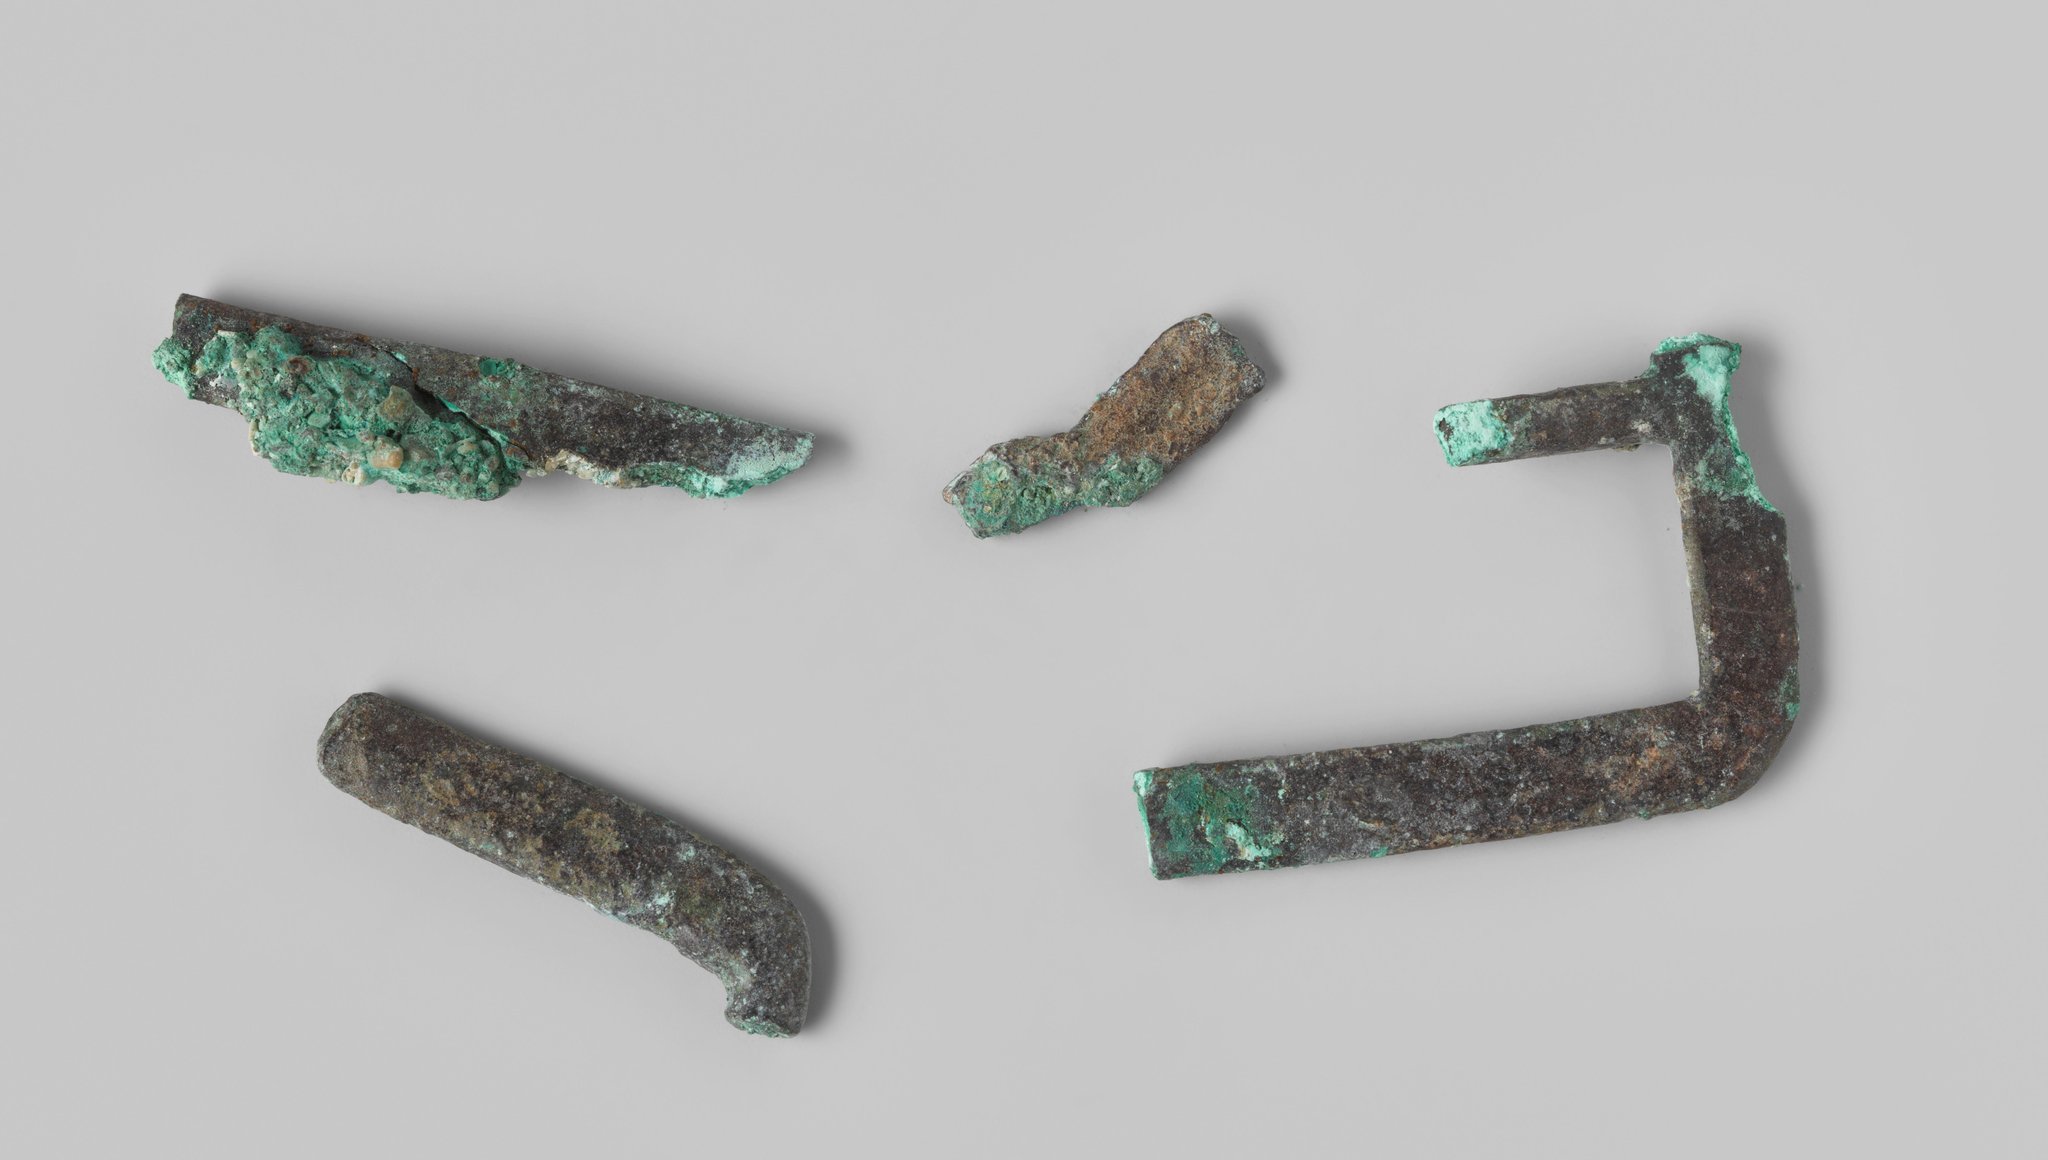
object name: belt buckle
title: Fragmenten riemgesp uit het wrak van de Oost-Indiëvaarder Hollandia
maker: Anonymous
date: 1700-1743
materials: copper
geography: netherlands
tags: verenigde oostindische compagnie, hollandia (schip), annet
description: Rectangular, fragm of rings, id. NG 1980-27H2852, belt buckle.